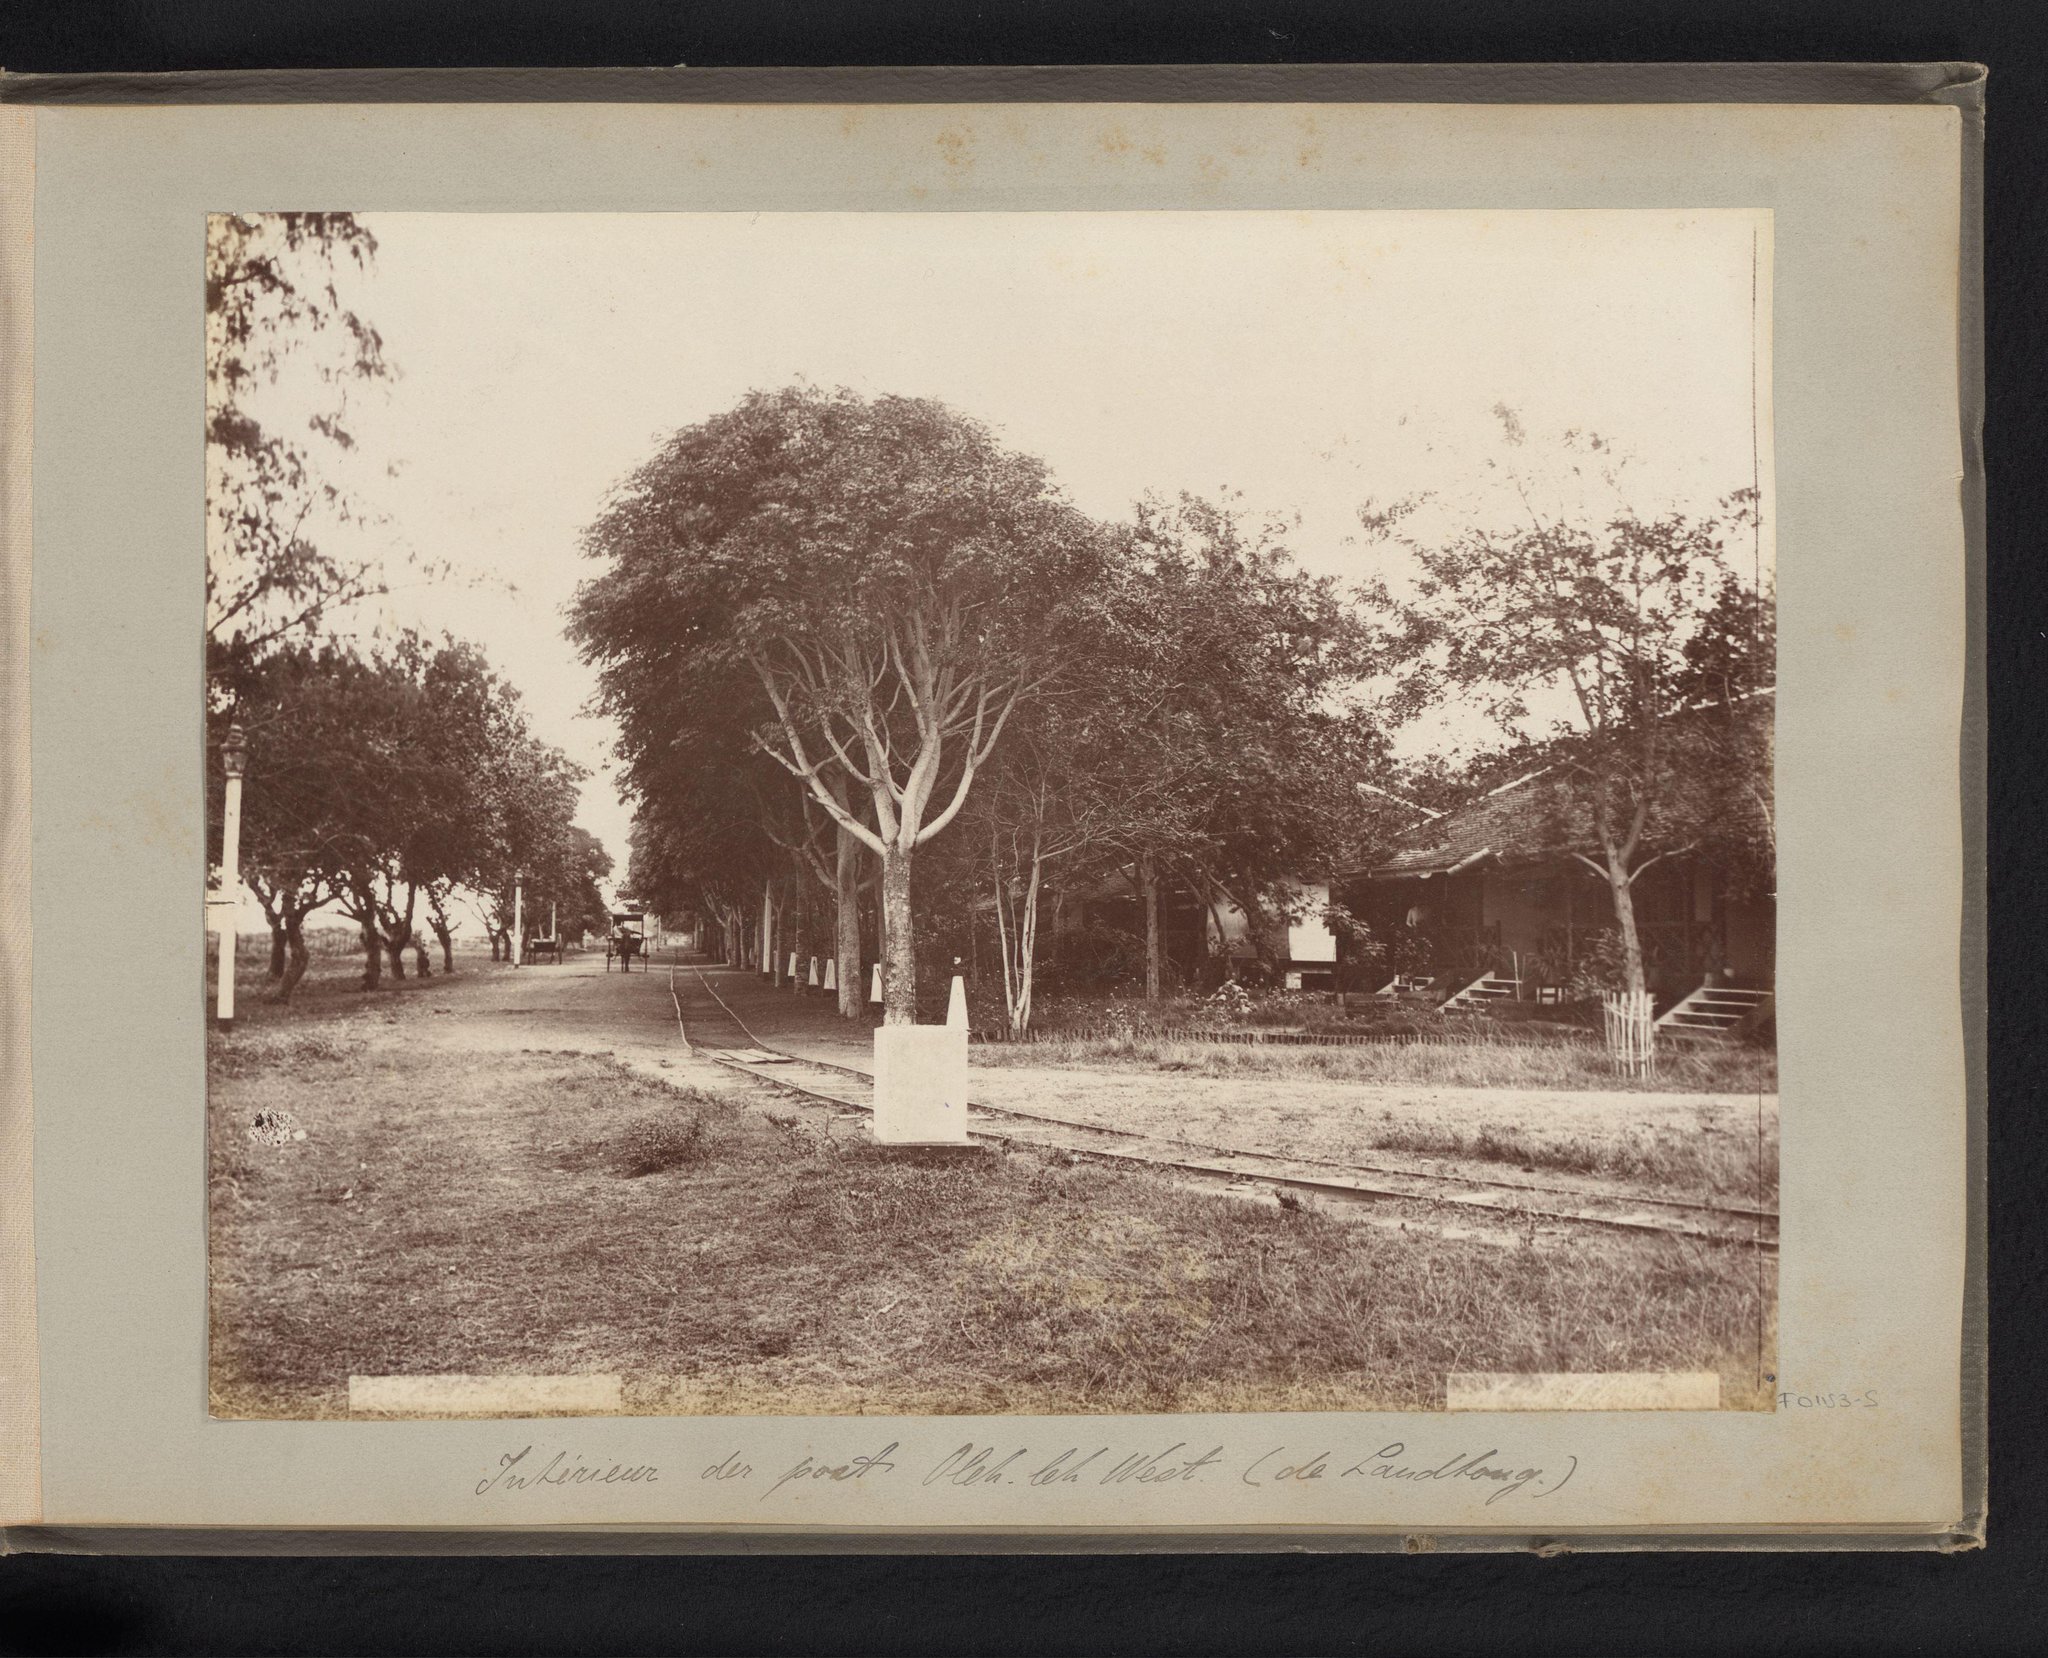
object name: photograph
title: Interieur der post Oleh-leh west (de Landtong)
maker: a. kaulfuss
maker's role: fotograaf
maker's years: 1861-1909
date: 1891-1894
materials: photographic support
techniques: albumen print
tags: trees, railway, train